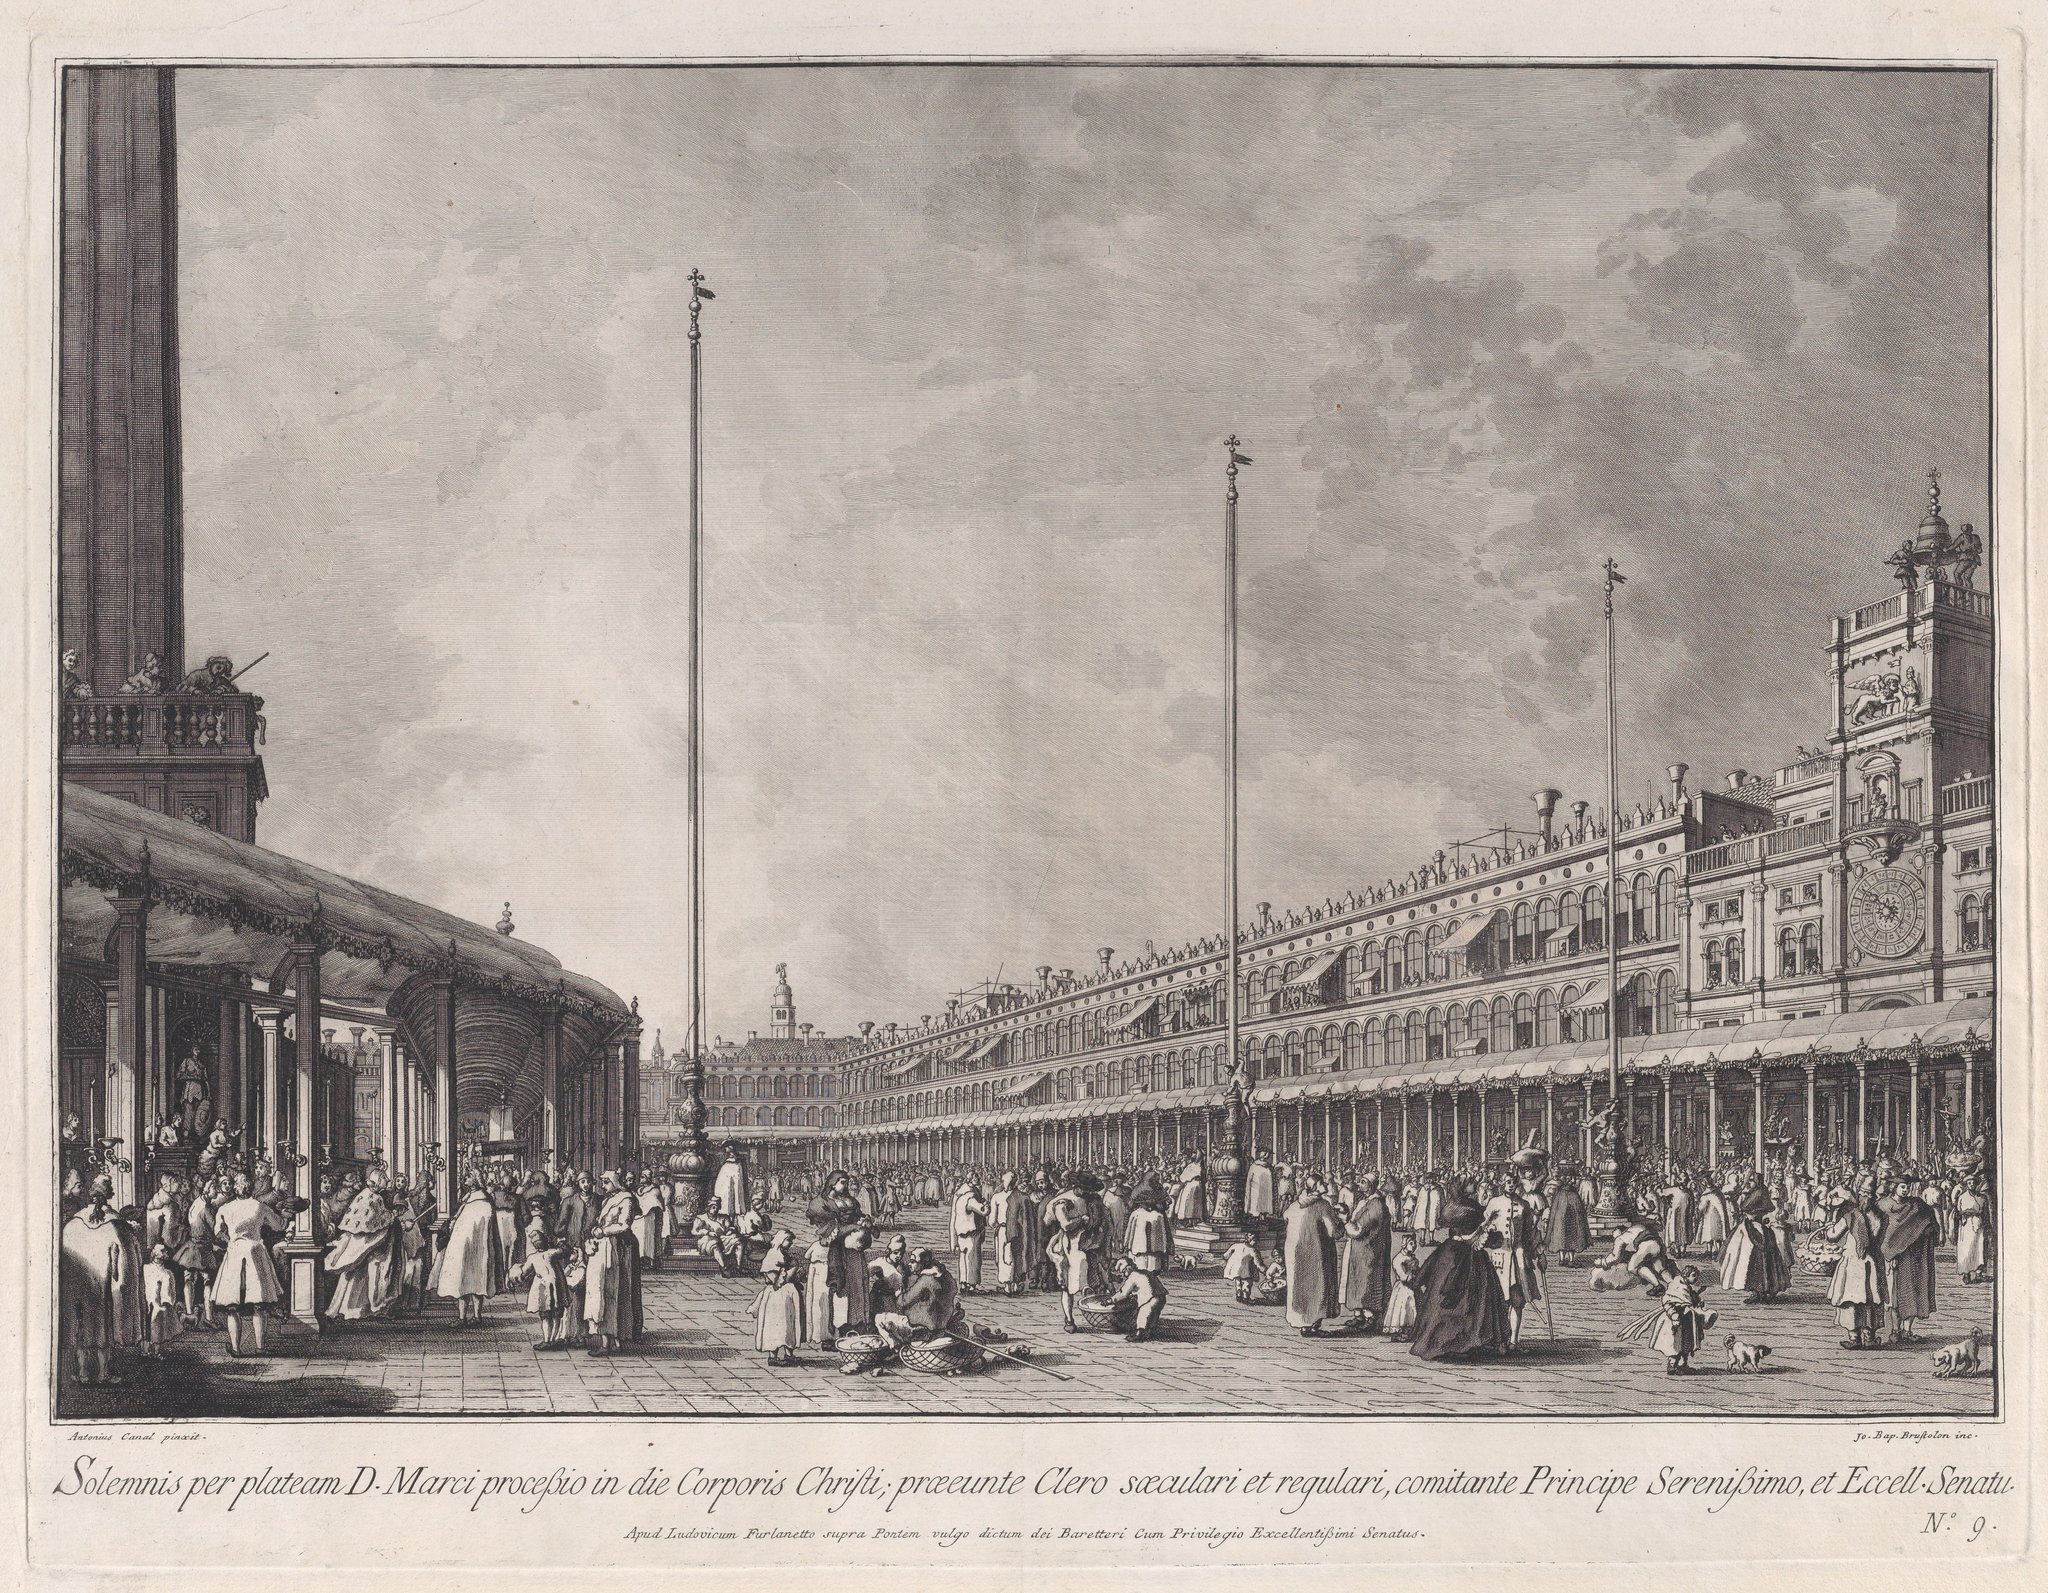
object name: print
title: Plate 9: Procession on Corpus Christi Day in the Piazza San Marco, from 'Ducal Ceremonies and Festivals' (Le Feste Ducali)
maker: giovanni battista brustolon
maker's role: artist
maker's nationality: italian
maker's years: 1712-1796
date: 1766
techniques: engraving, etching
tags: venice